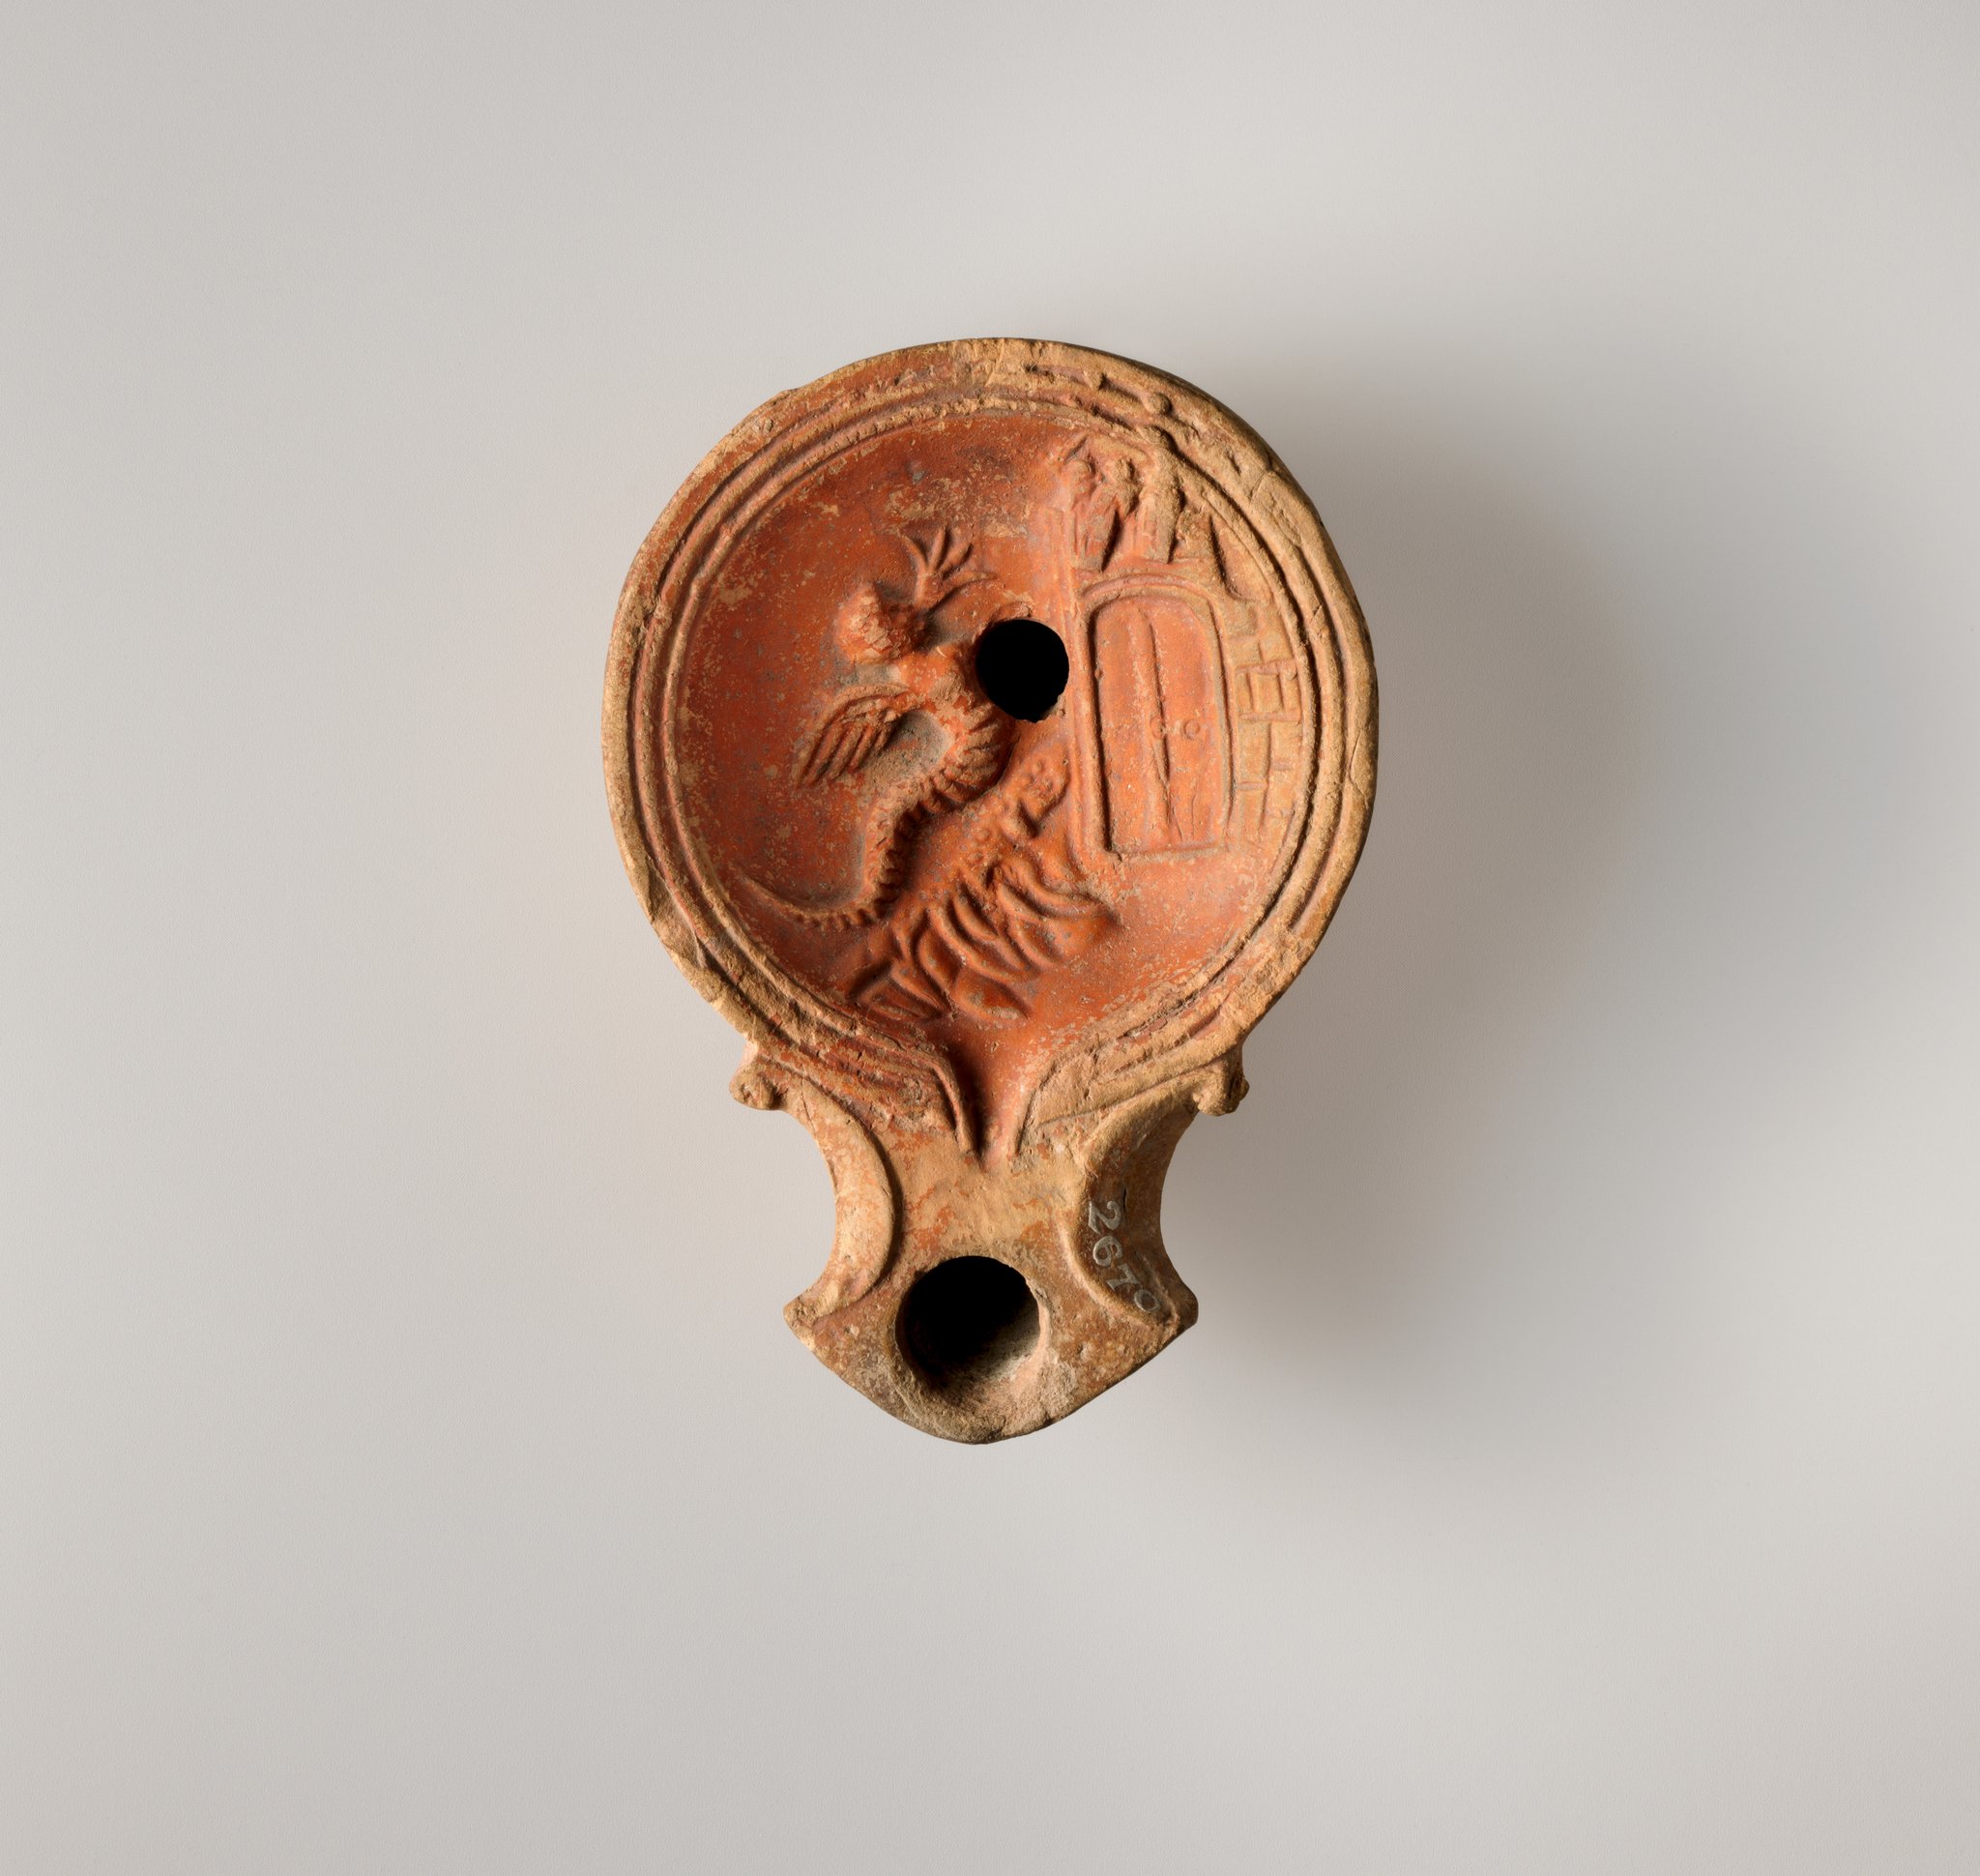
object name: lamp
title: Terracotta oil lamp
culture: roman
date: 40-100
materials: terracotta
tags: monsters